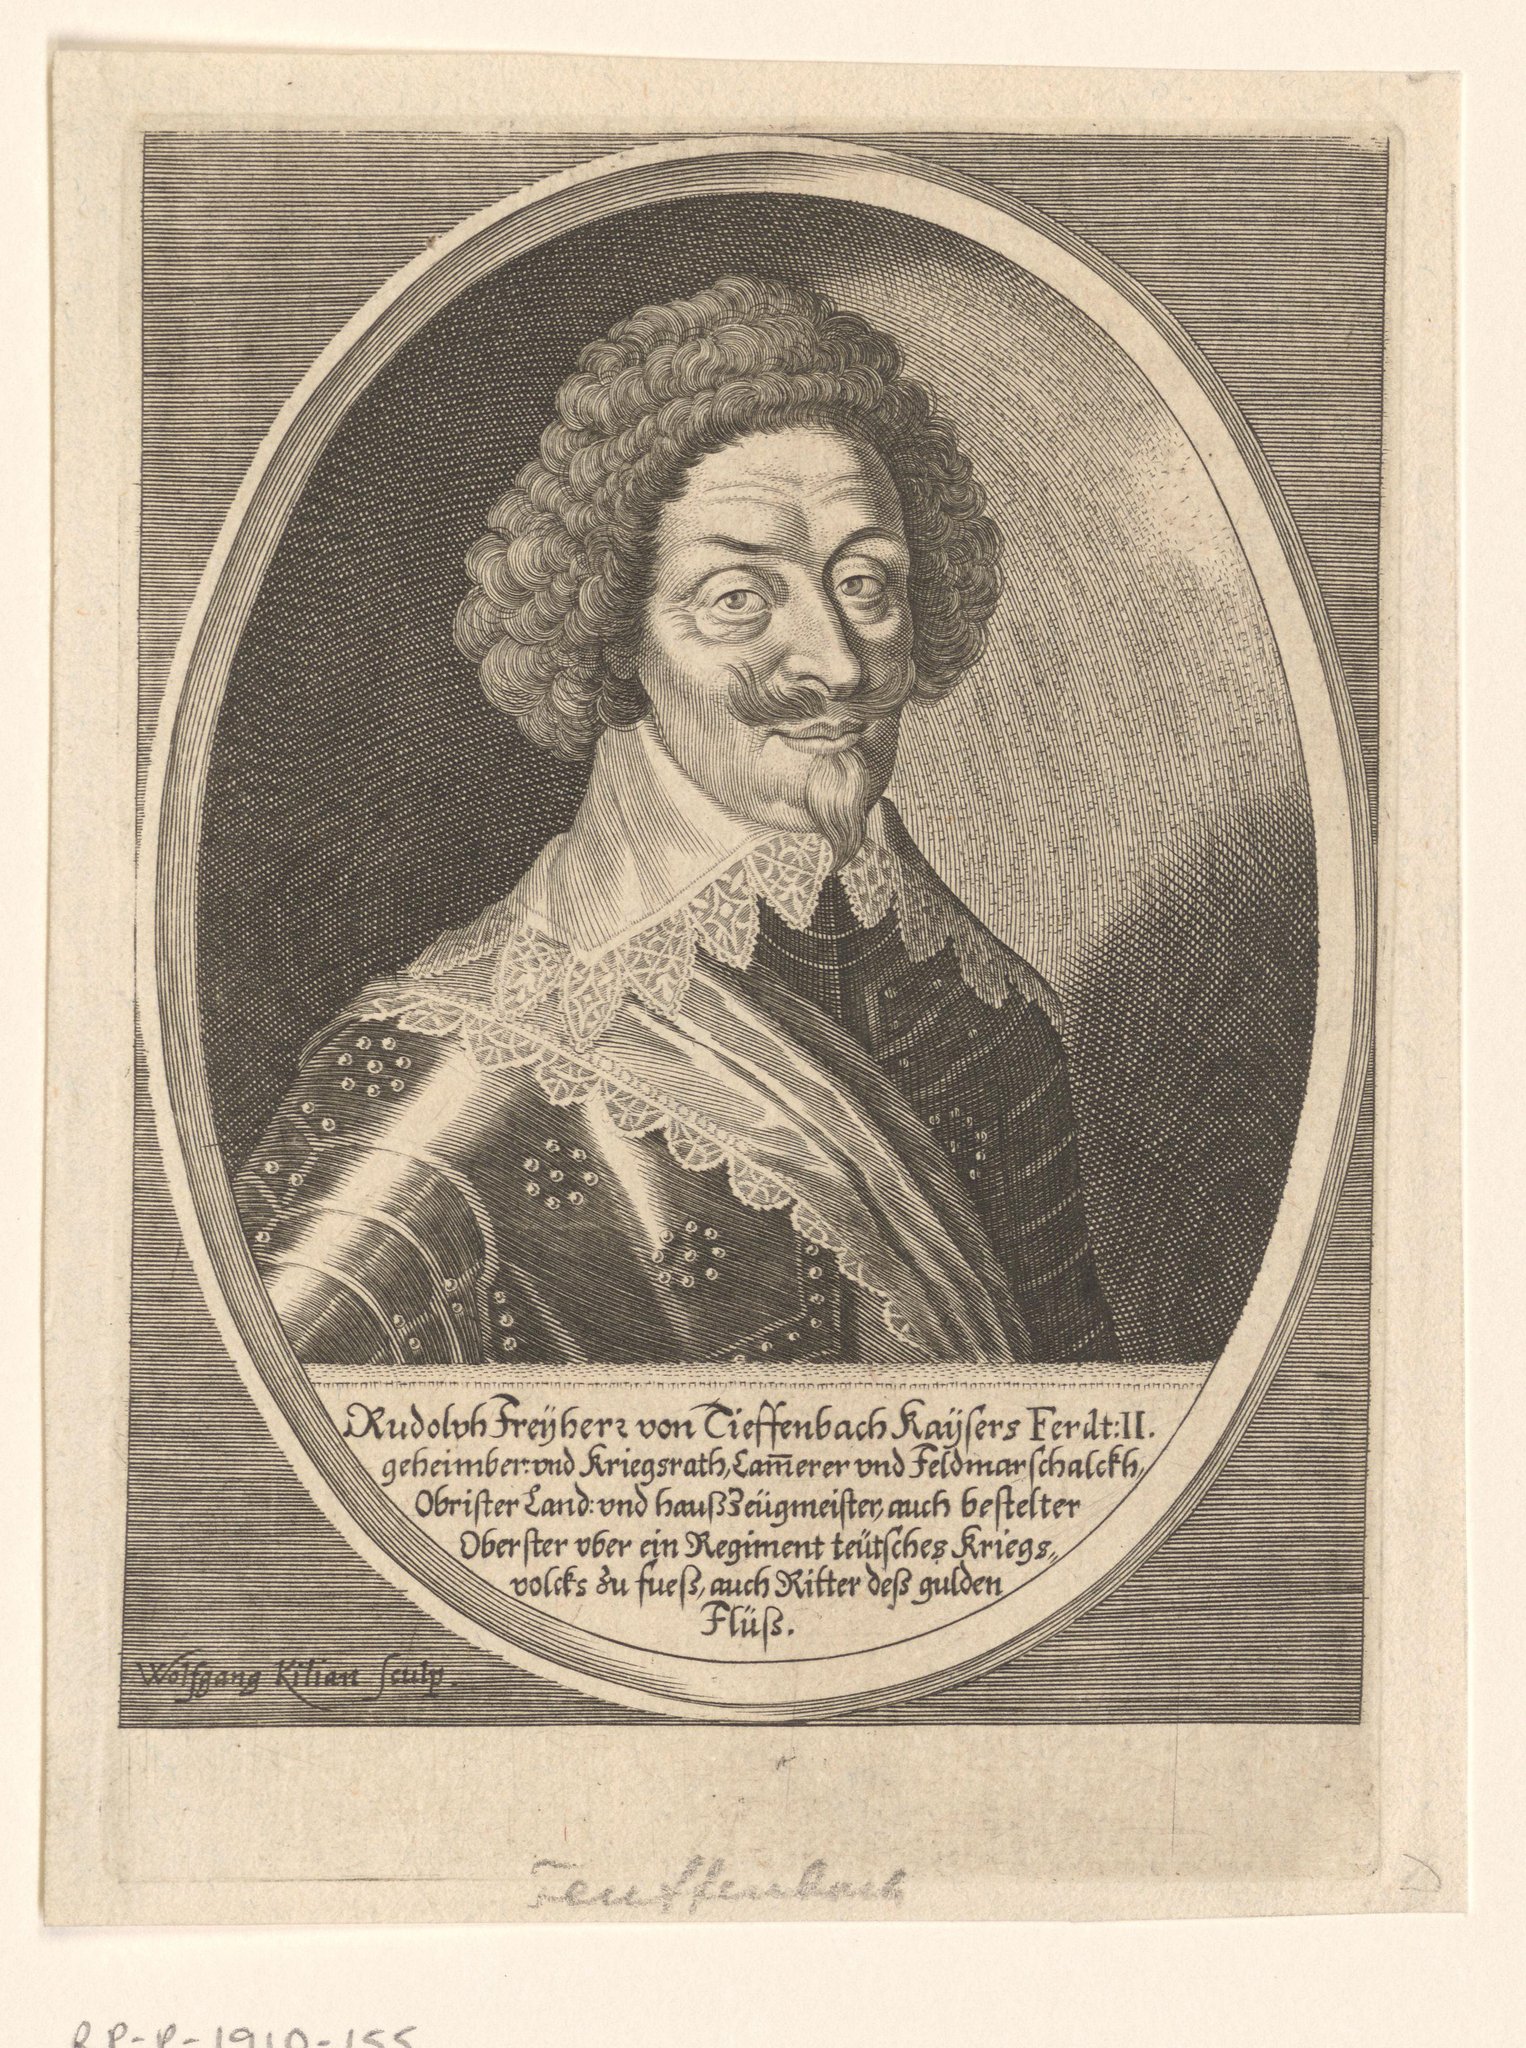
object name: print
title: Portret van Rudolf von Teuffenbach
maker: wolfgang kilian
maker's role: print maker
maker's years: 1581-1662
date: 1634-1662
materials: paper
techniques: engraving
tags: commander-in-chief, general, marshal, armour, historical persons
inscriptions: collector's mark: Lugt 2228